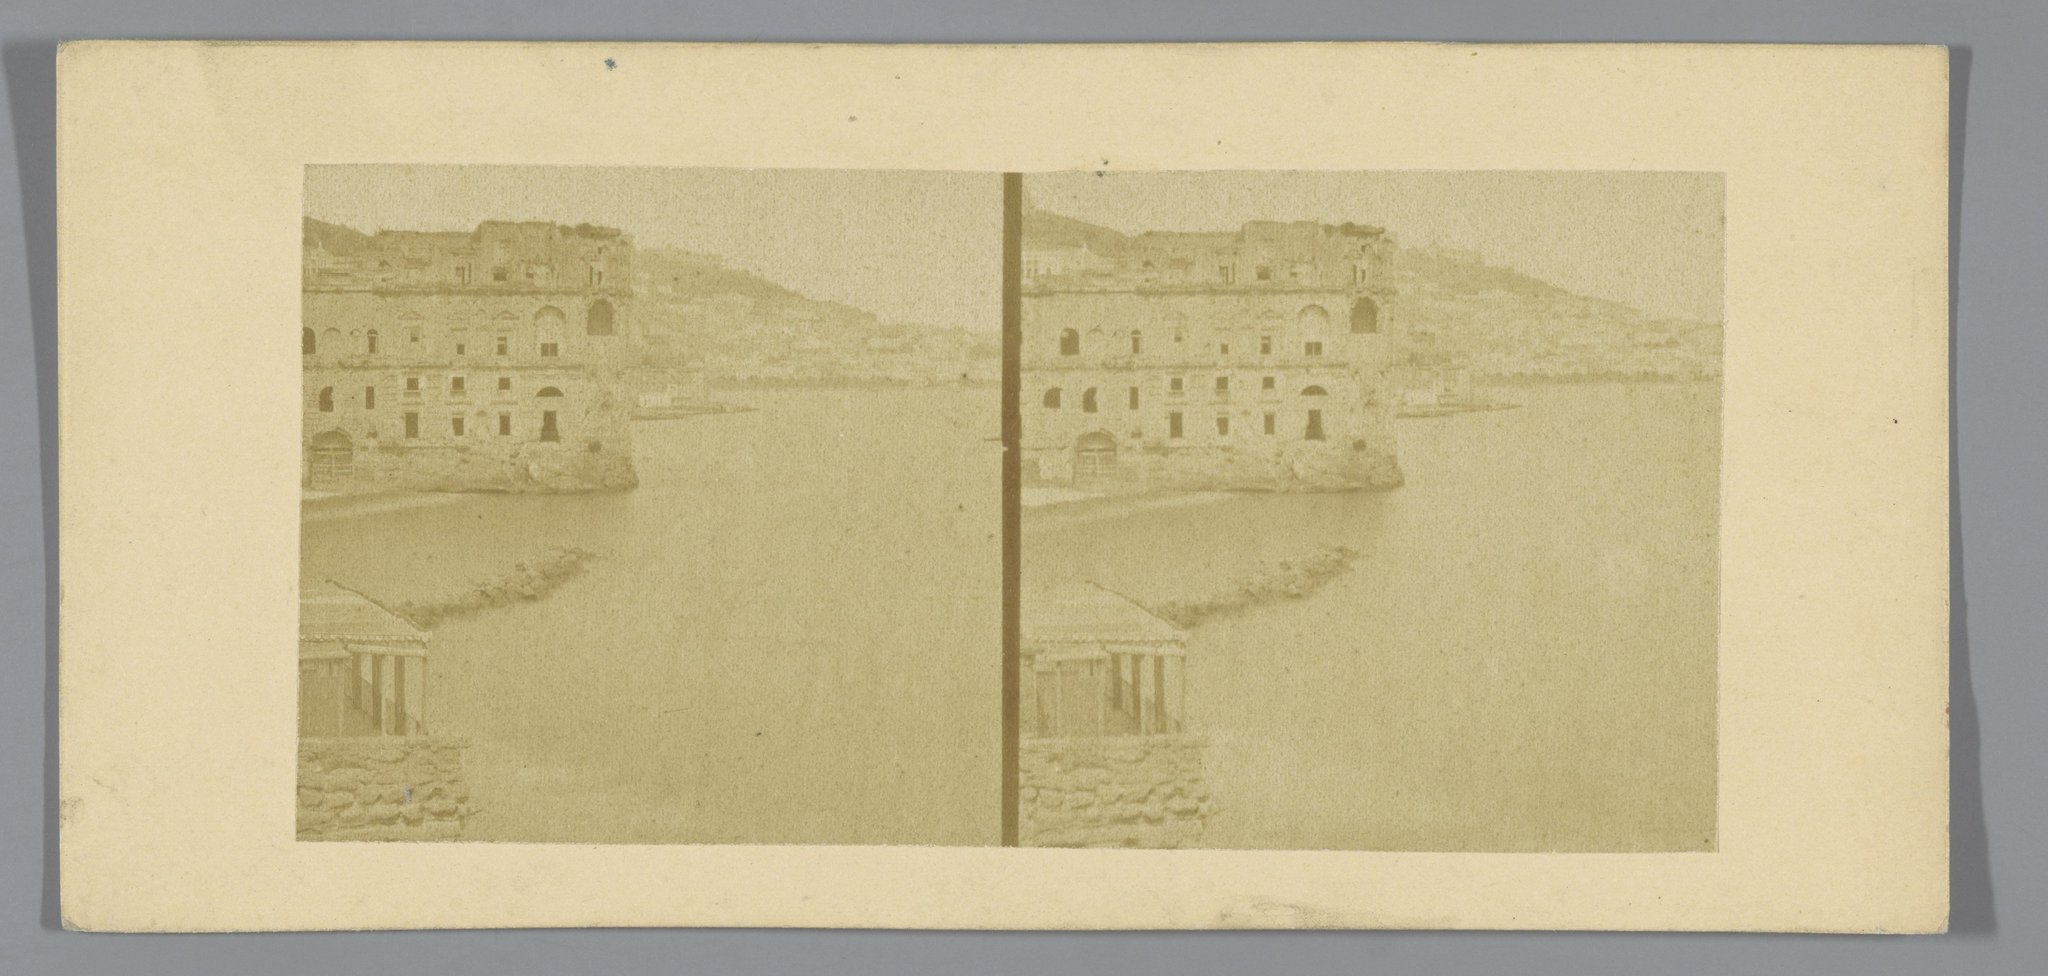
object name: stereograph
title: Gezicht op een stad aan een baai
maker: Anonymous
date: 1852-1858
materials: cardboard, paper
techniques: albumen print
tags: gulf, bay, city-view in general; 'veduta'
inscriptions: number: ‘6’